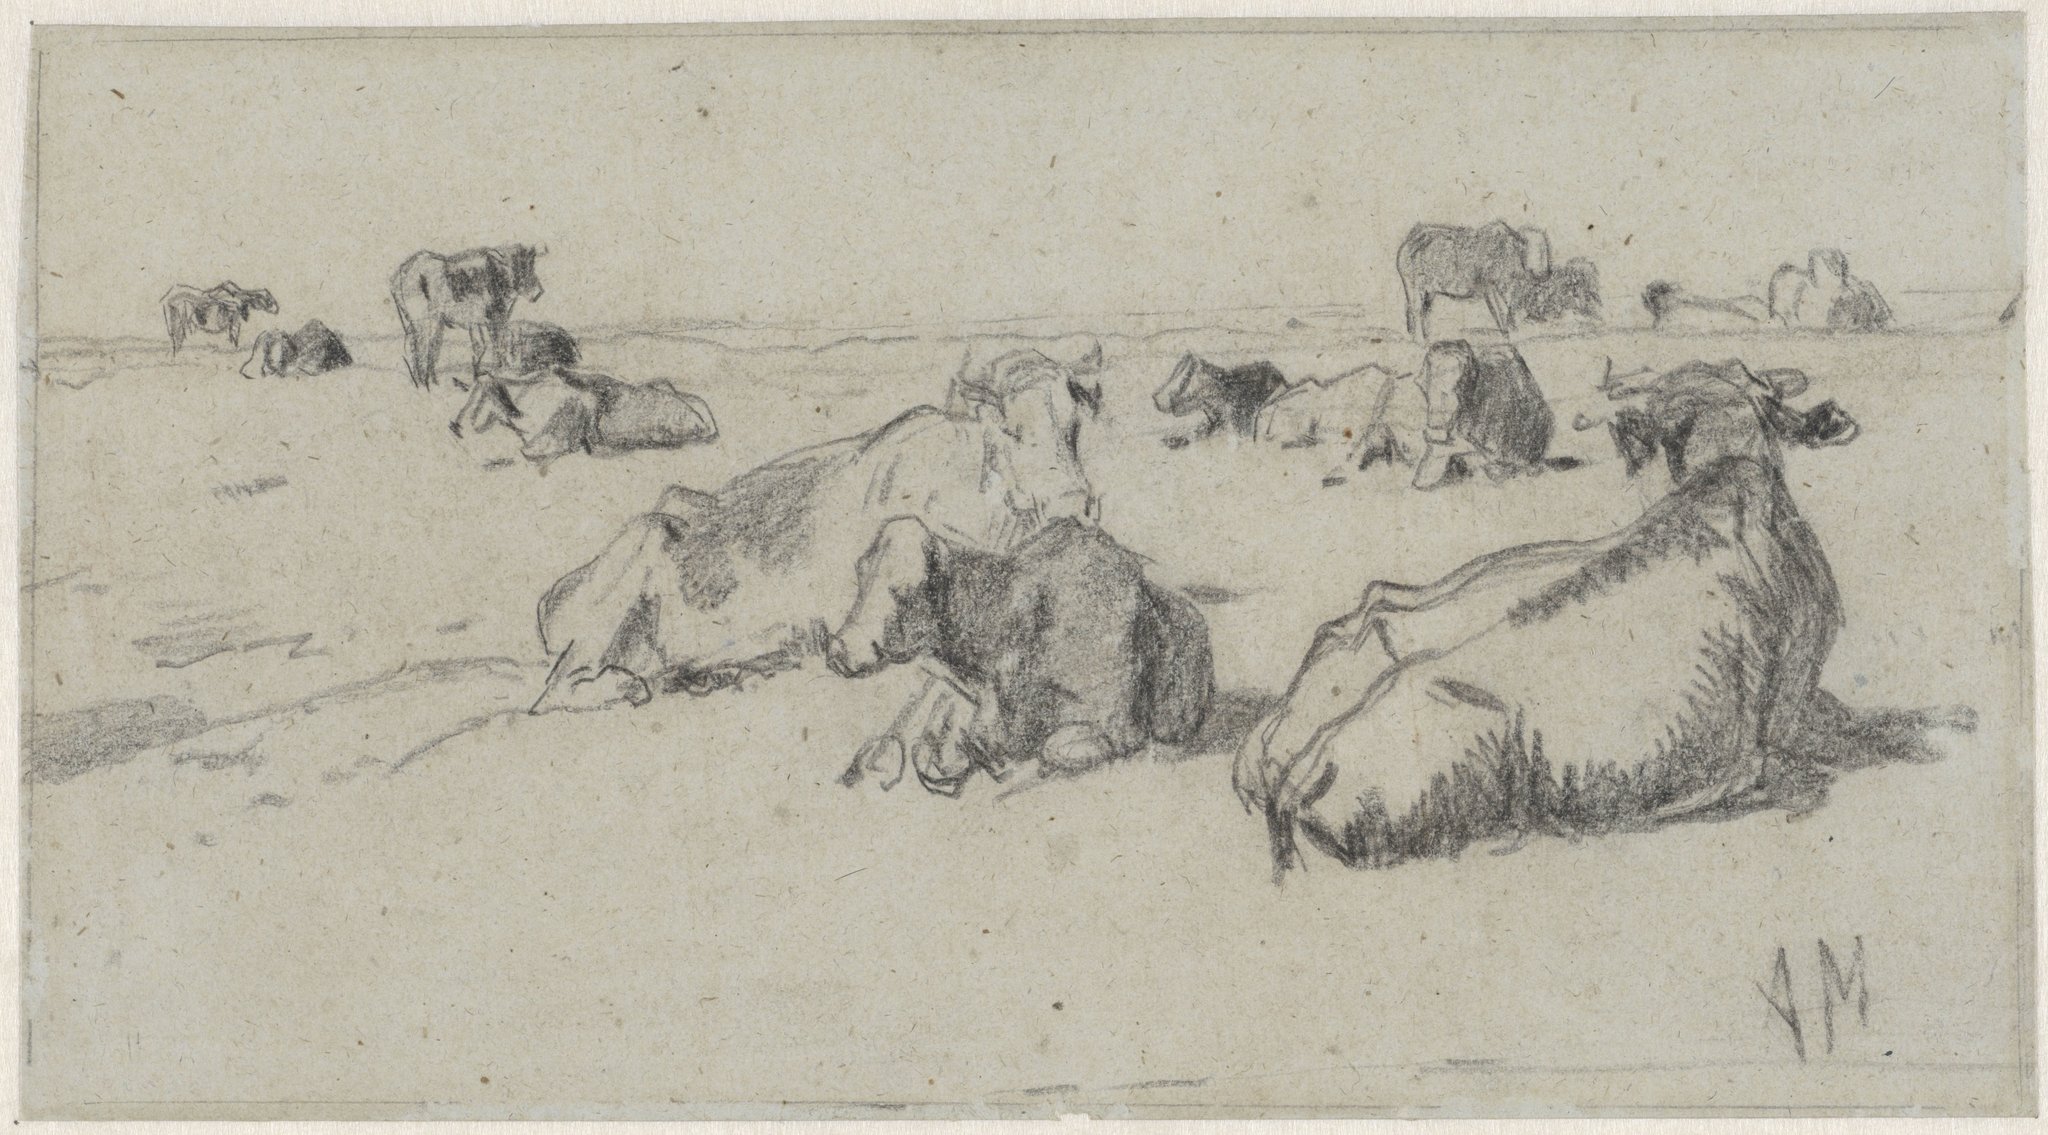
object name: drawing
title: Liggende koeien in een weiland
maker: anton mauve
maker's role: draughtsman, painter, print maker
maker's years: 1838-1888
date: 1848-1888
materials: chalk, paper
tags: cow